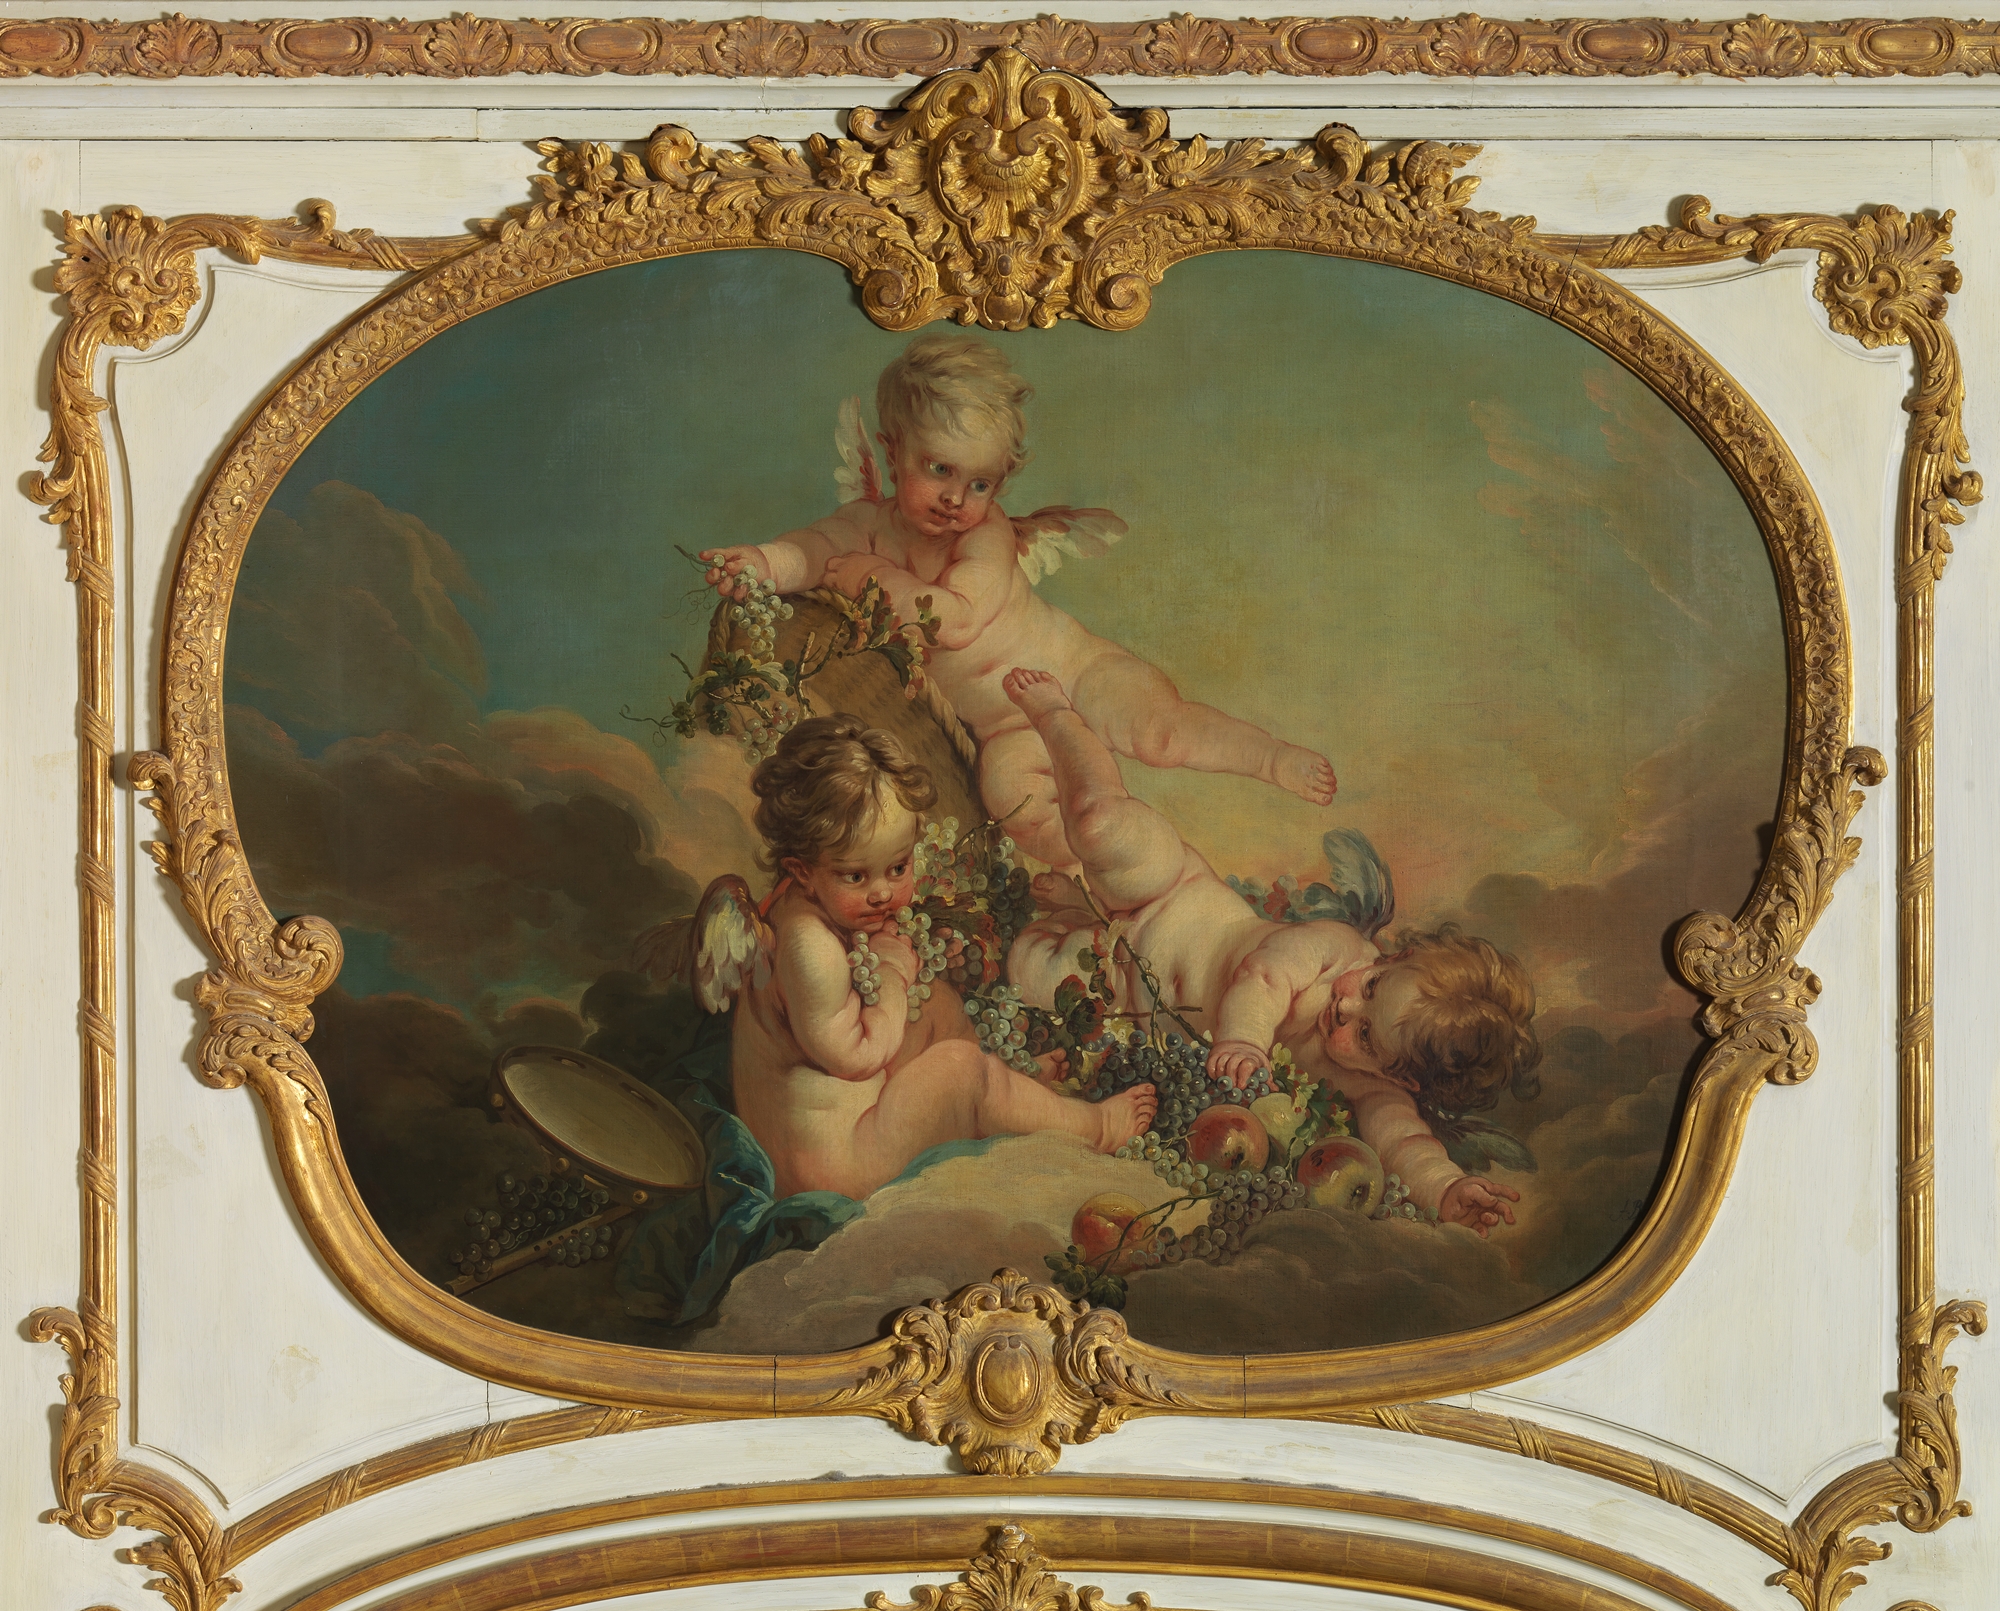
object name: painting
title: Allegory of Autumn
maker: françois boucher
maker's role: artist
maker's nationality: french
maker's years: 1703-1770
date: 1753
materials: canvas, oil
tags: apples,grapes,putti,allegory